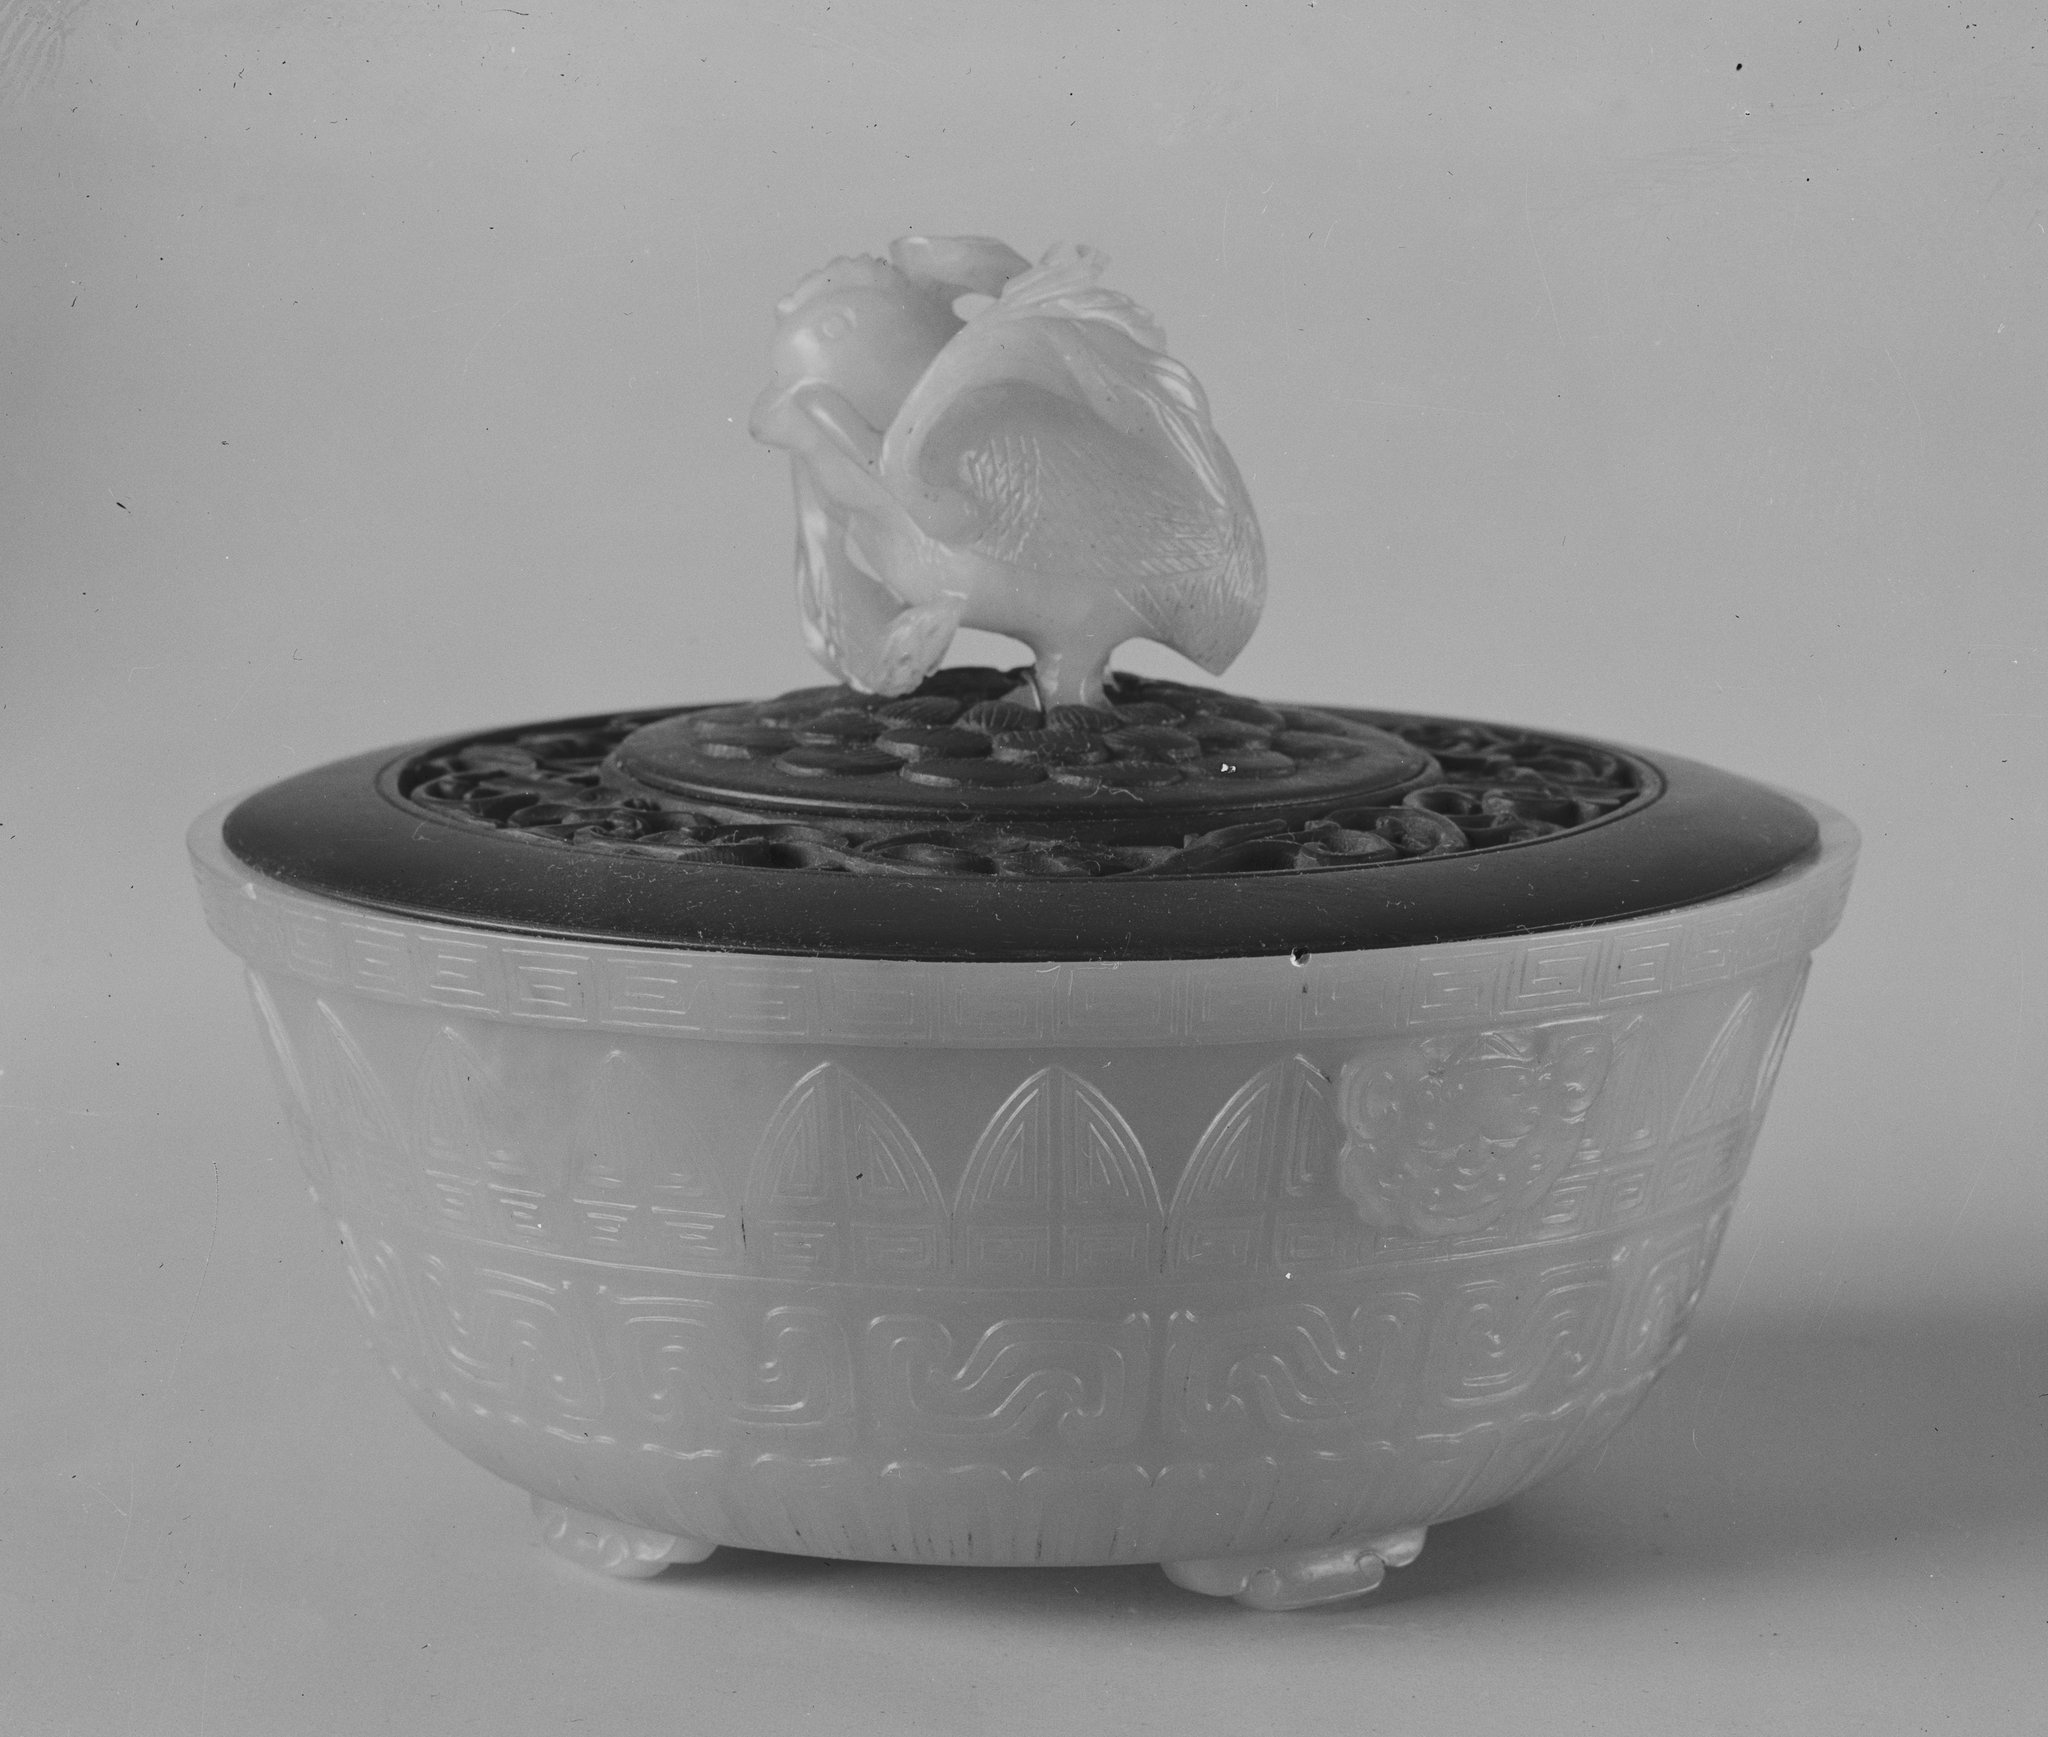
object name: bowl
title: Bowl with archaic design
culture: chinese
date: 1801-1900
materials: jade